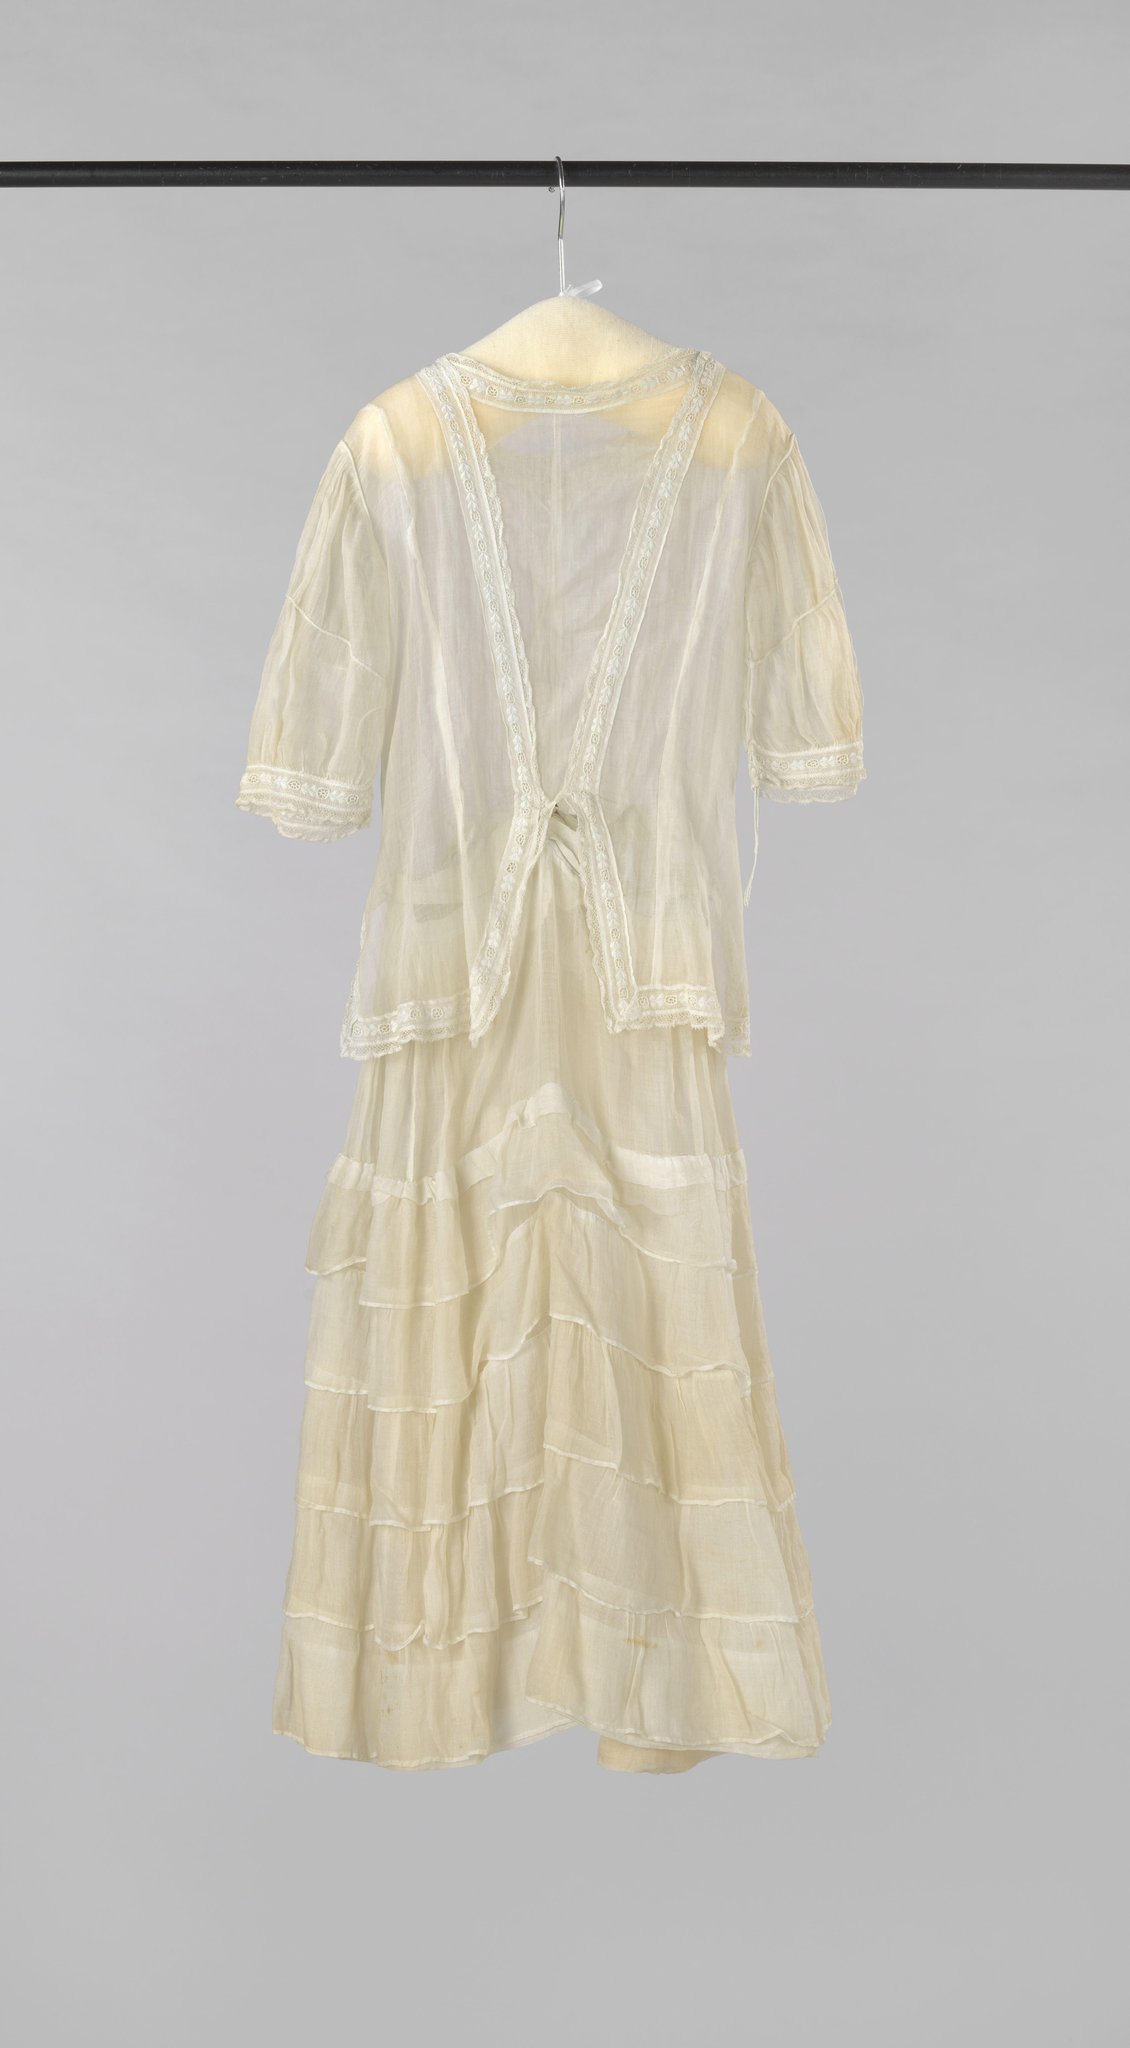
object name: girls' wear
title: Rok van een kinderjurk van neteldoek, versierd met brede ruches.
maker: Anonymous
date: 1875-1880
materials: textile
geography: netherlands